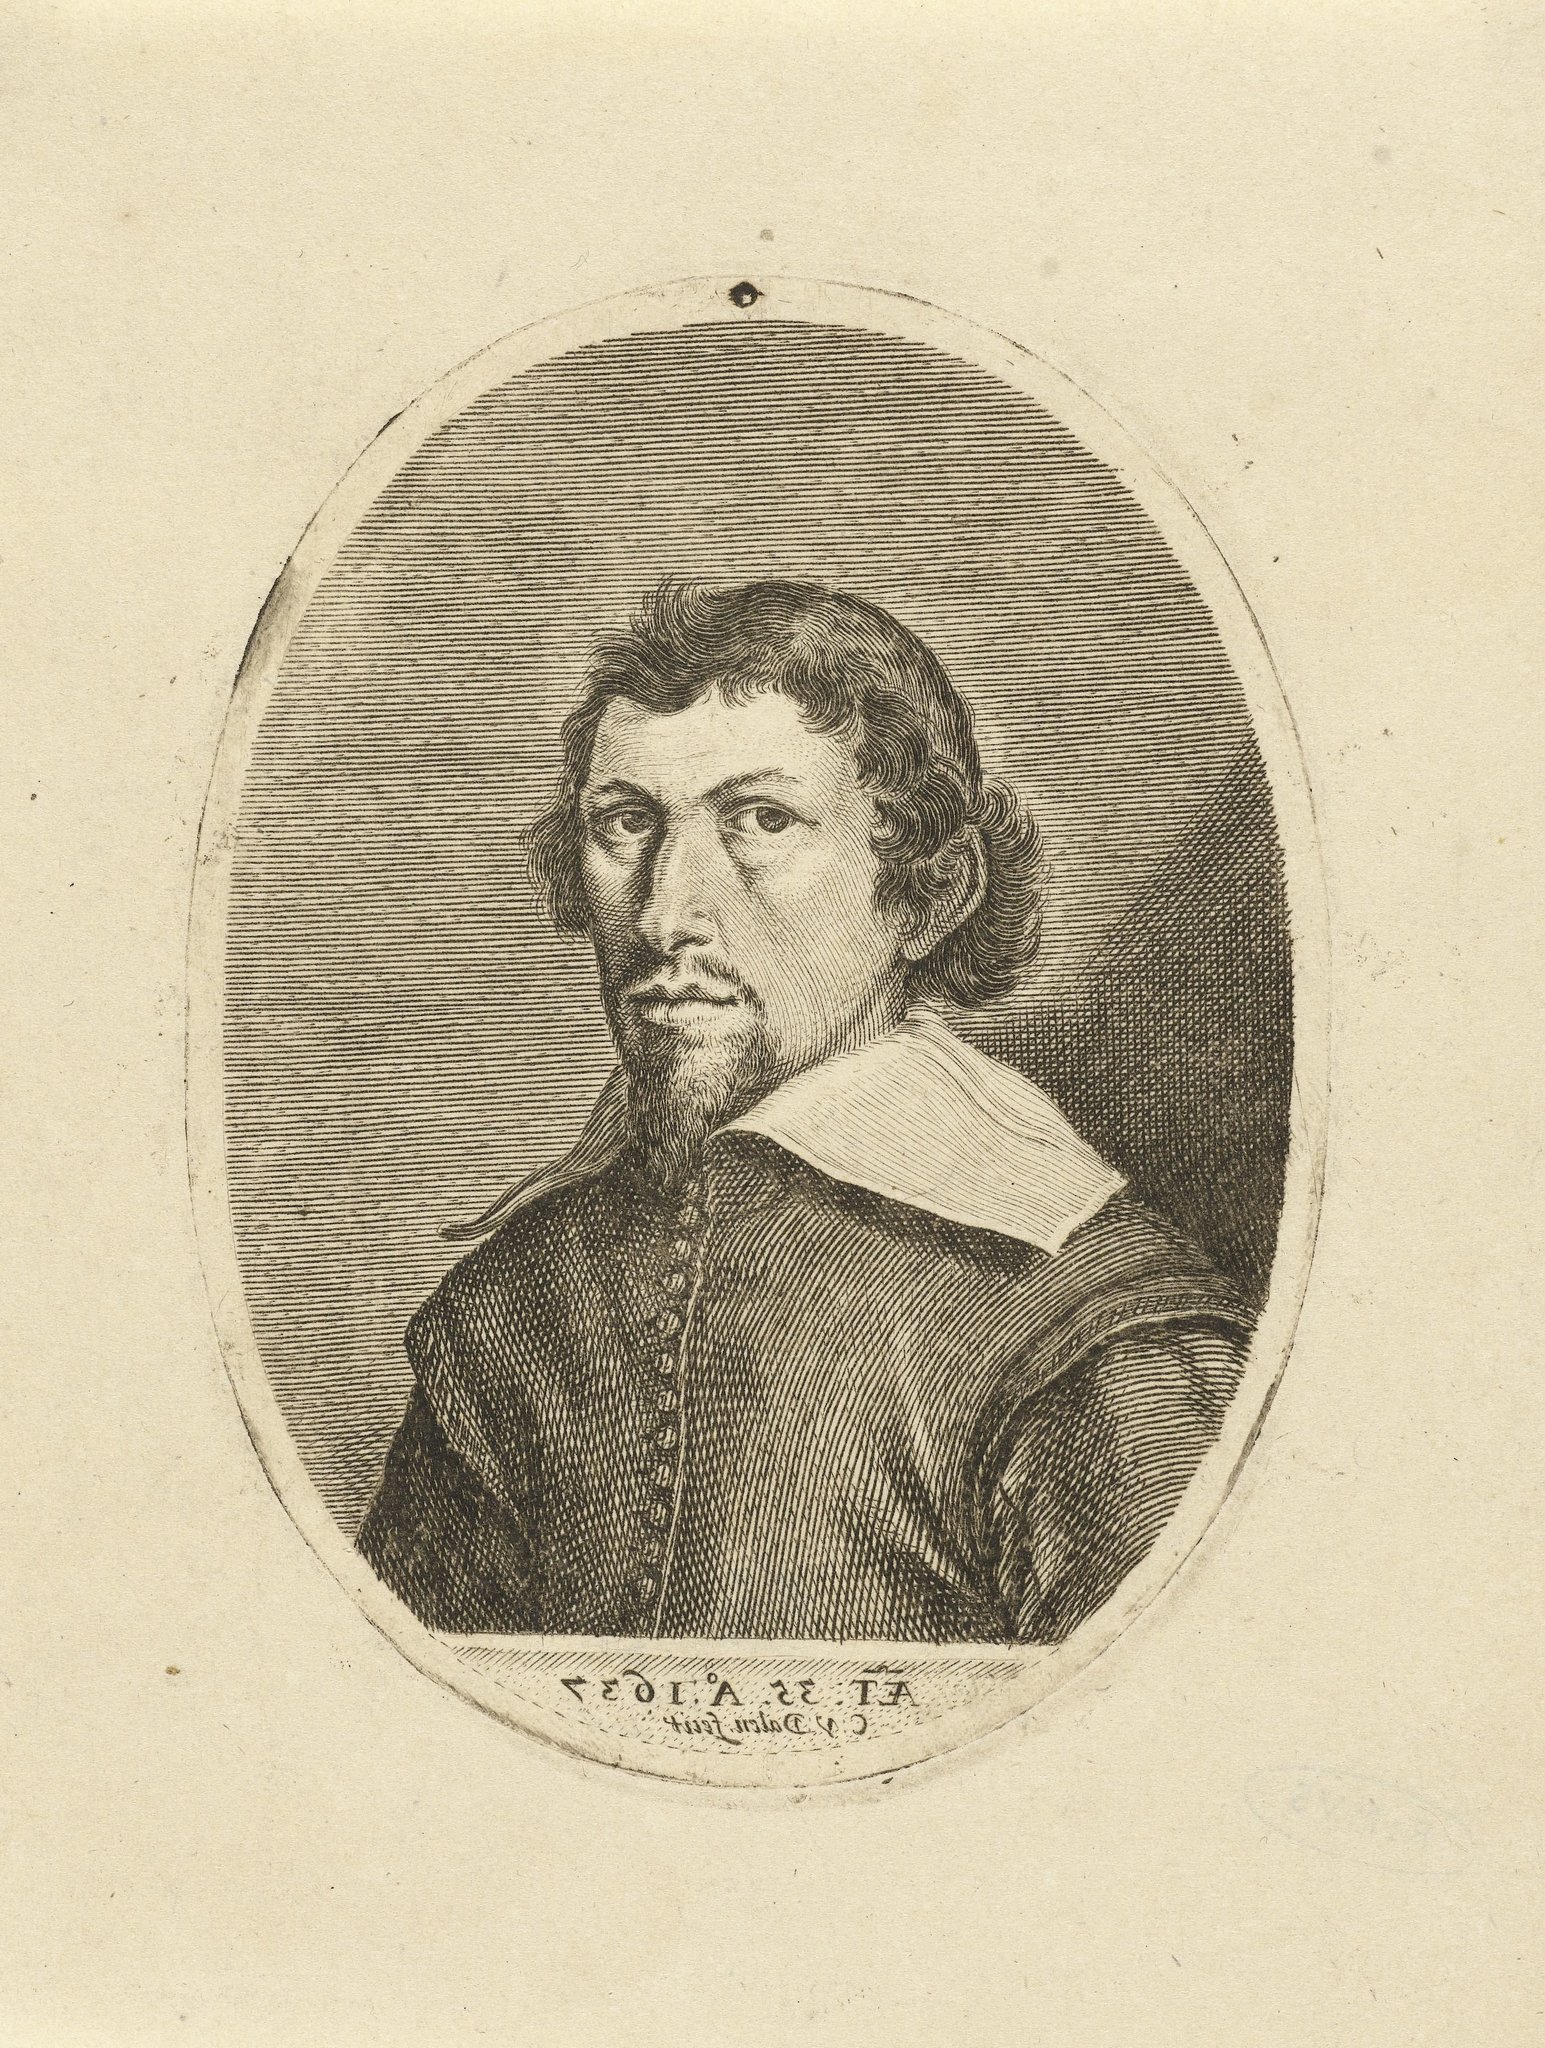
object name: print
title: Zelfportret op 35-jarige leeftijd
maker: cornelis van dalen (i)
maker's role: print maker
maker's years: 1602-1665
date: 1637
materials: paper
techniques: engraving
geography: great britain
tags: amsterdam, print maker, cornelis van dalen (i), portrait, self-portrait of graphic artist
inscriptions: collector's mark: Lugt 2228